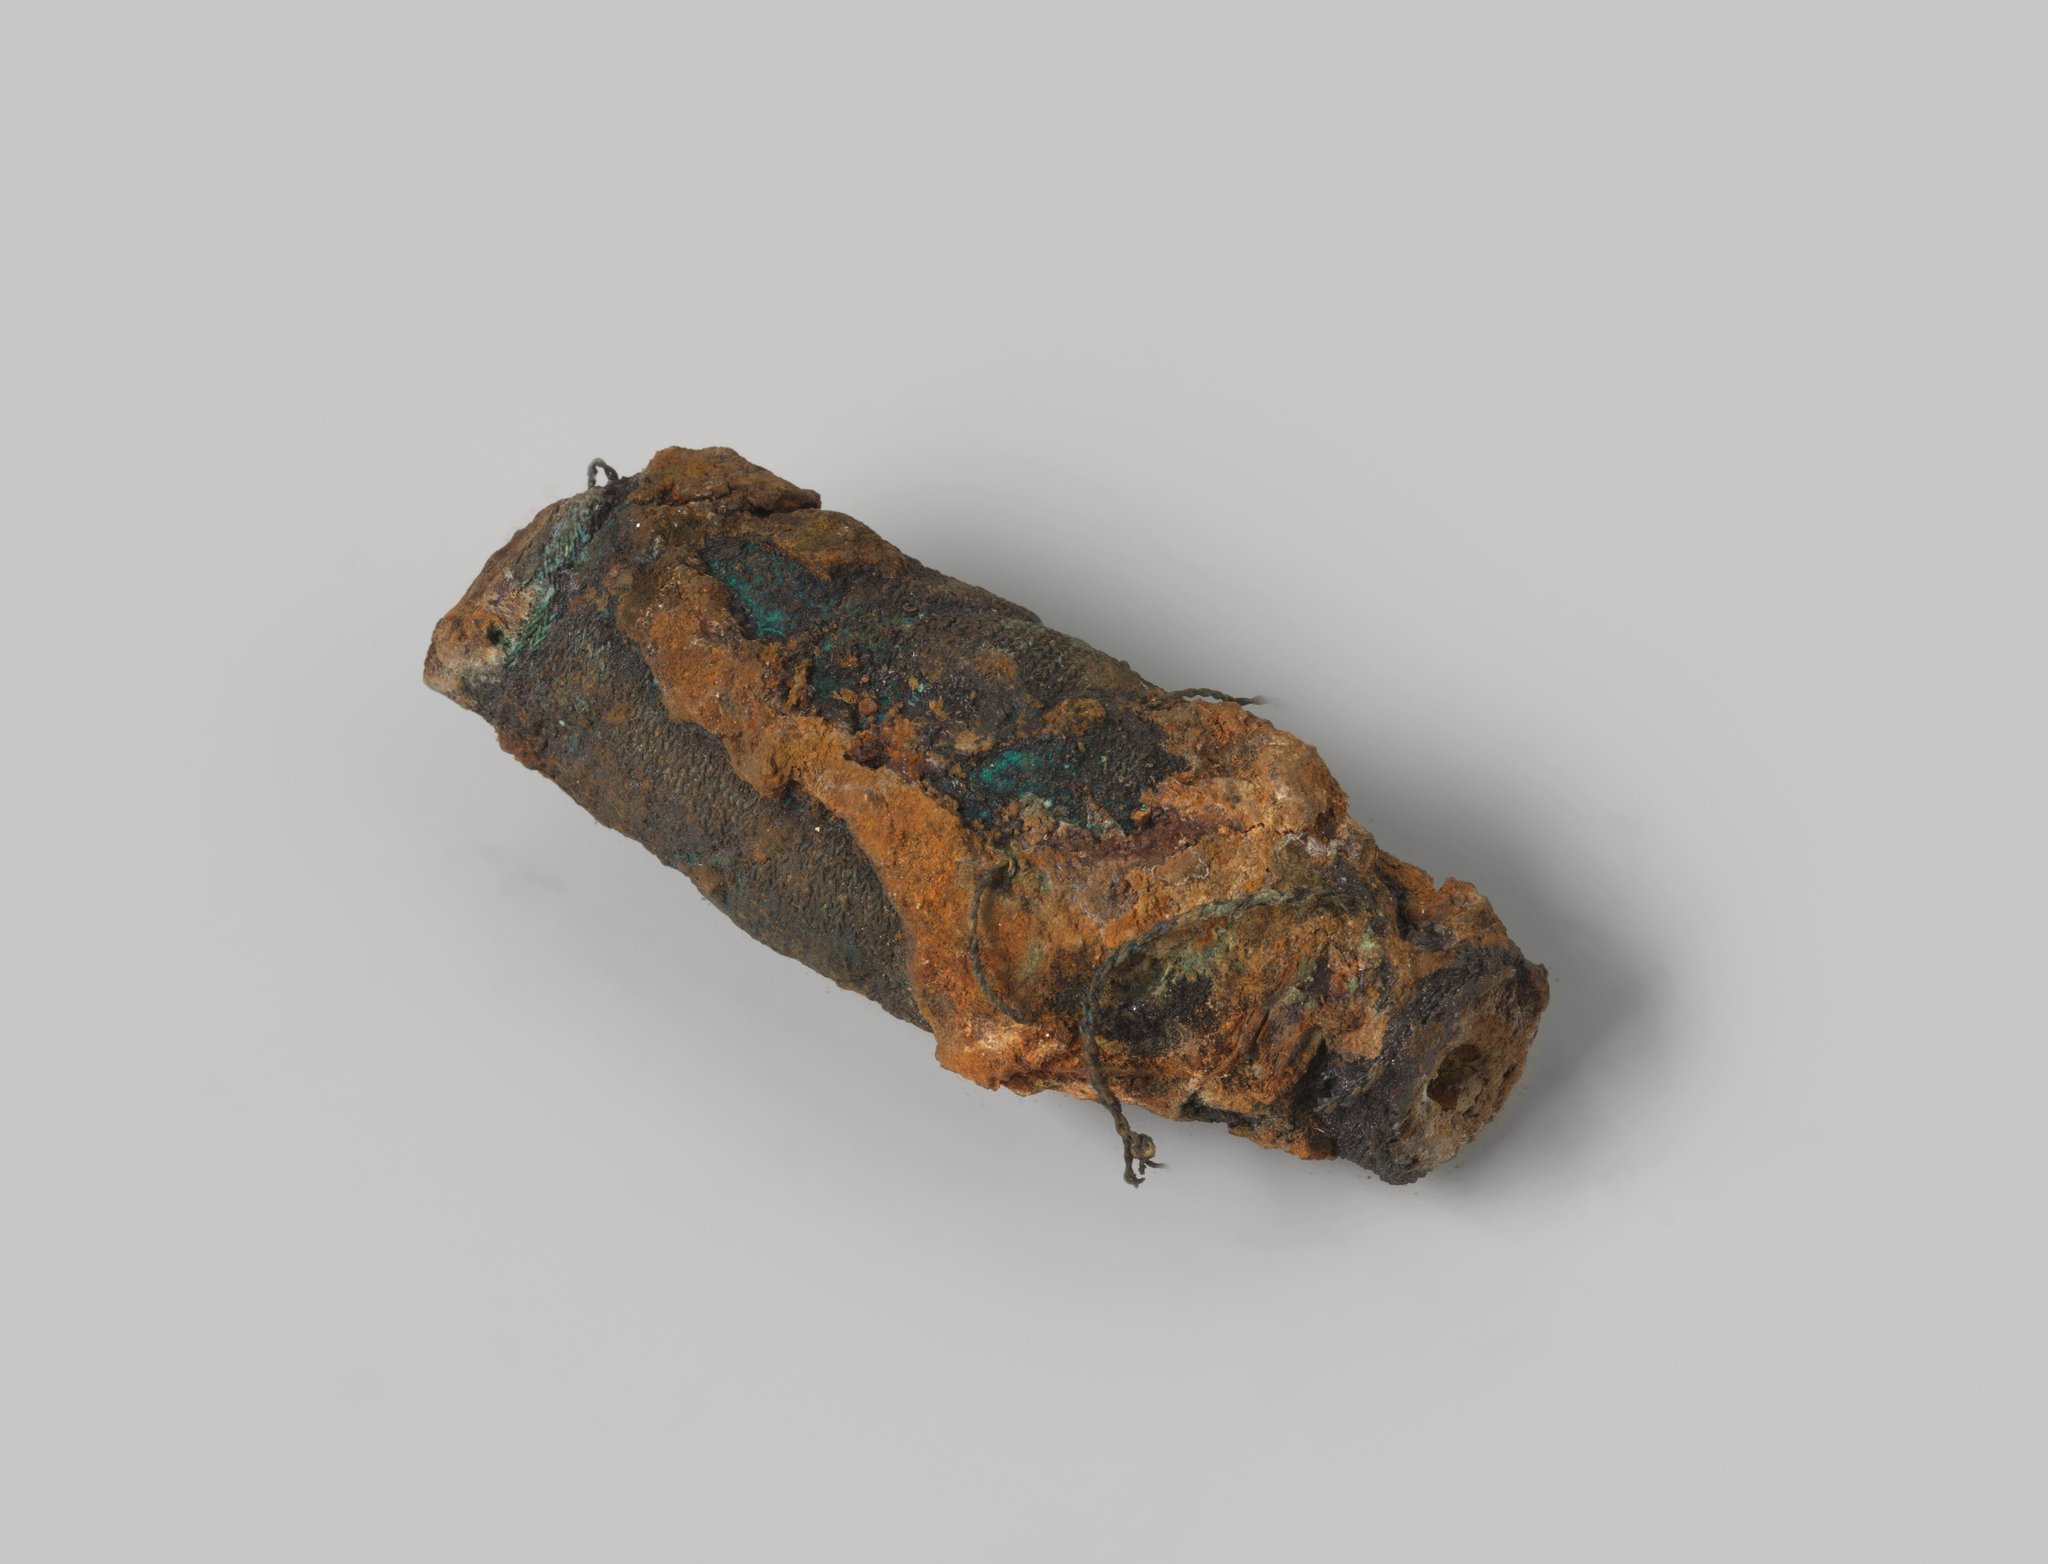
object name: greep gevest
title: Greep met concretie van een gevest uit het wrak van de Oost-Indiëvaarder Hollandia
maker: Anonymous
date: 1700-1743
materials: stone, copper, wood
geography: netherlands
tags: verenigde oostindische compagnie, hollandia (schip), annet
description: Hilt, grip; id. NG 1980-27H2582, 1 ferrule missing.